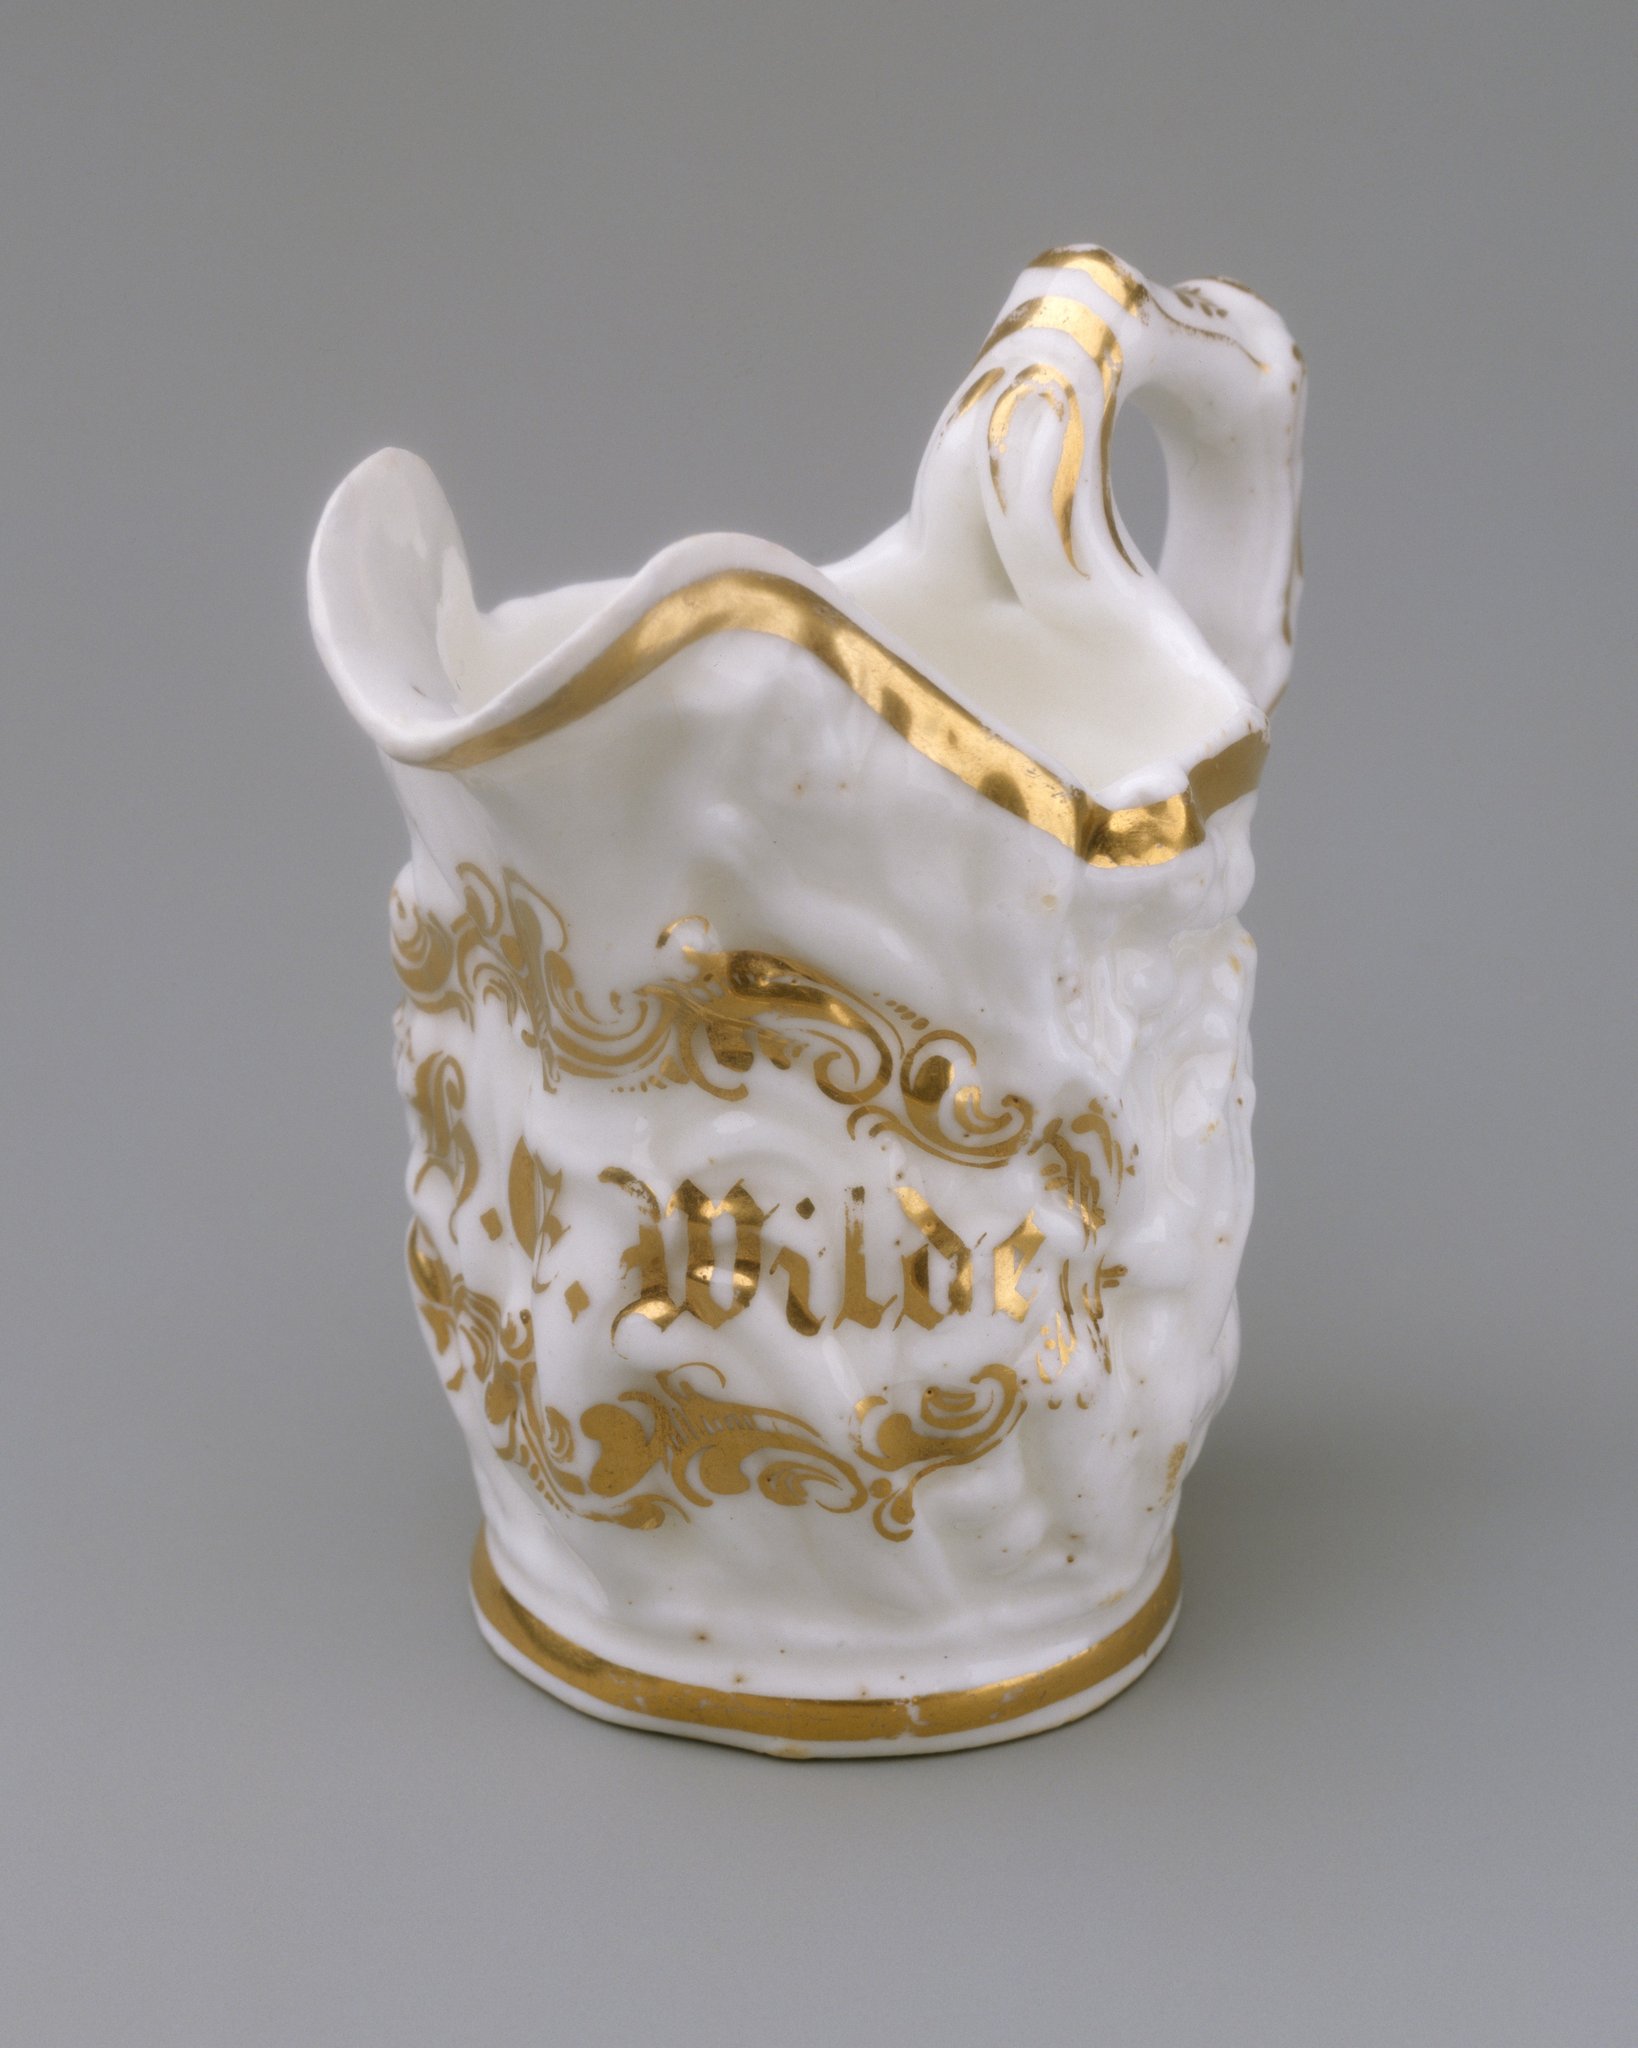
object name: pitcher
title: Miniature pitcher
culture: american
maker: charles cartlidge and company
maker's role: maker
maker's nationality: american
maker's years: 1848-1856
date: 1848-1856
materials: porcelain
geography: united states